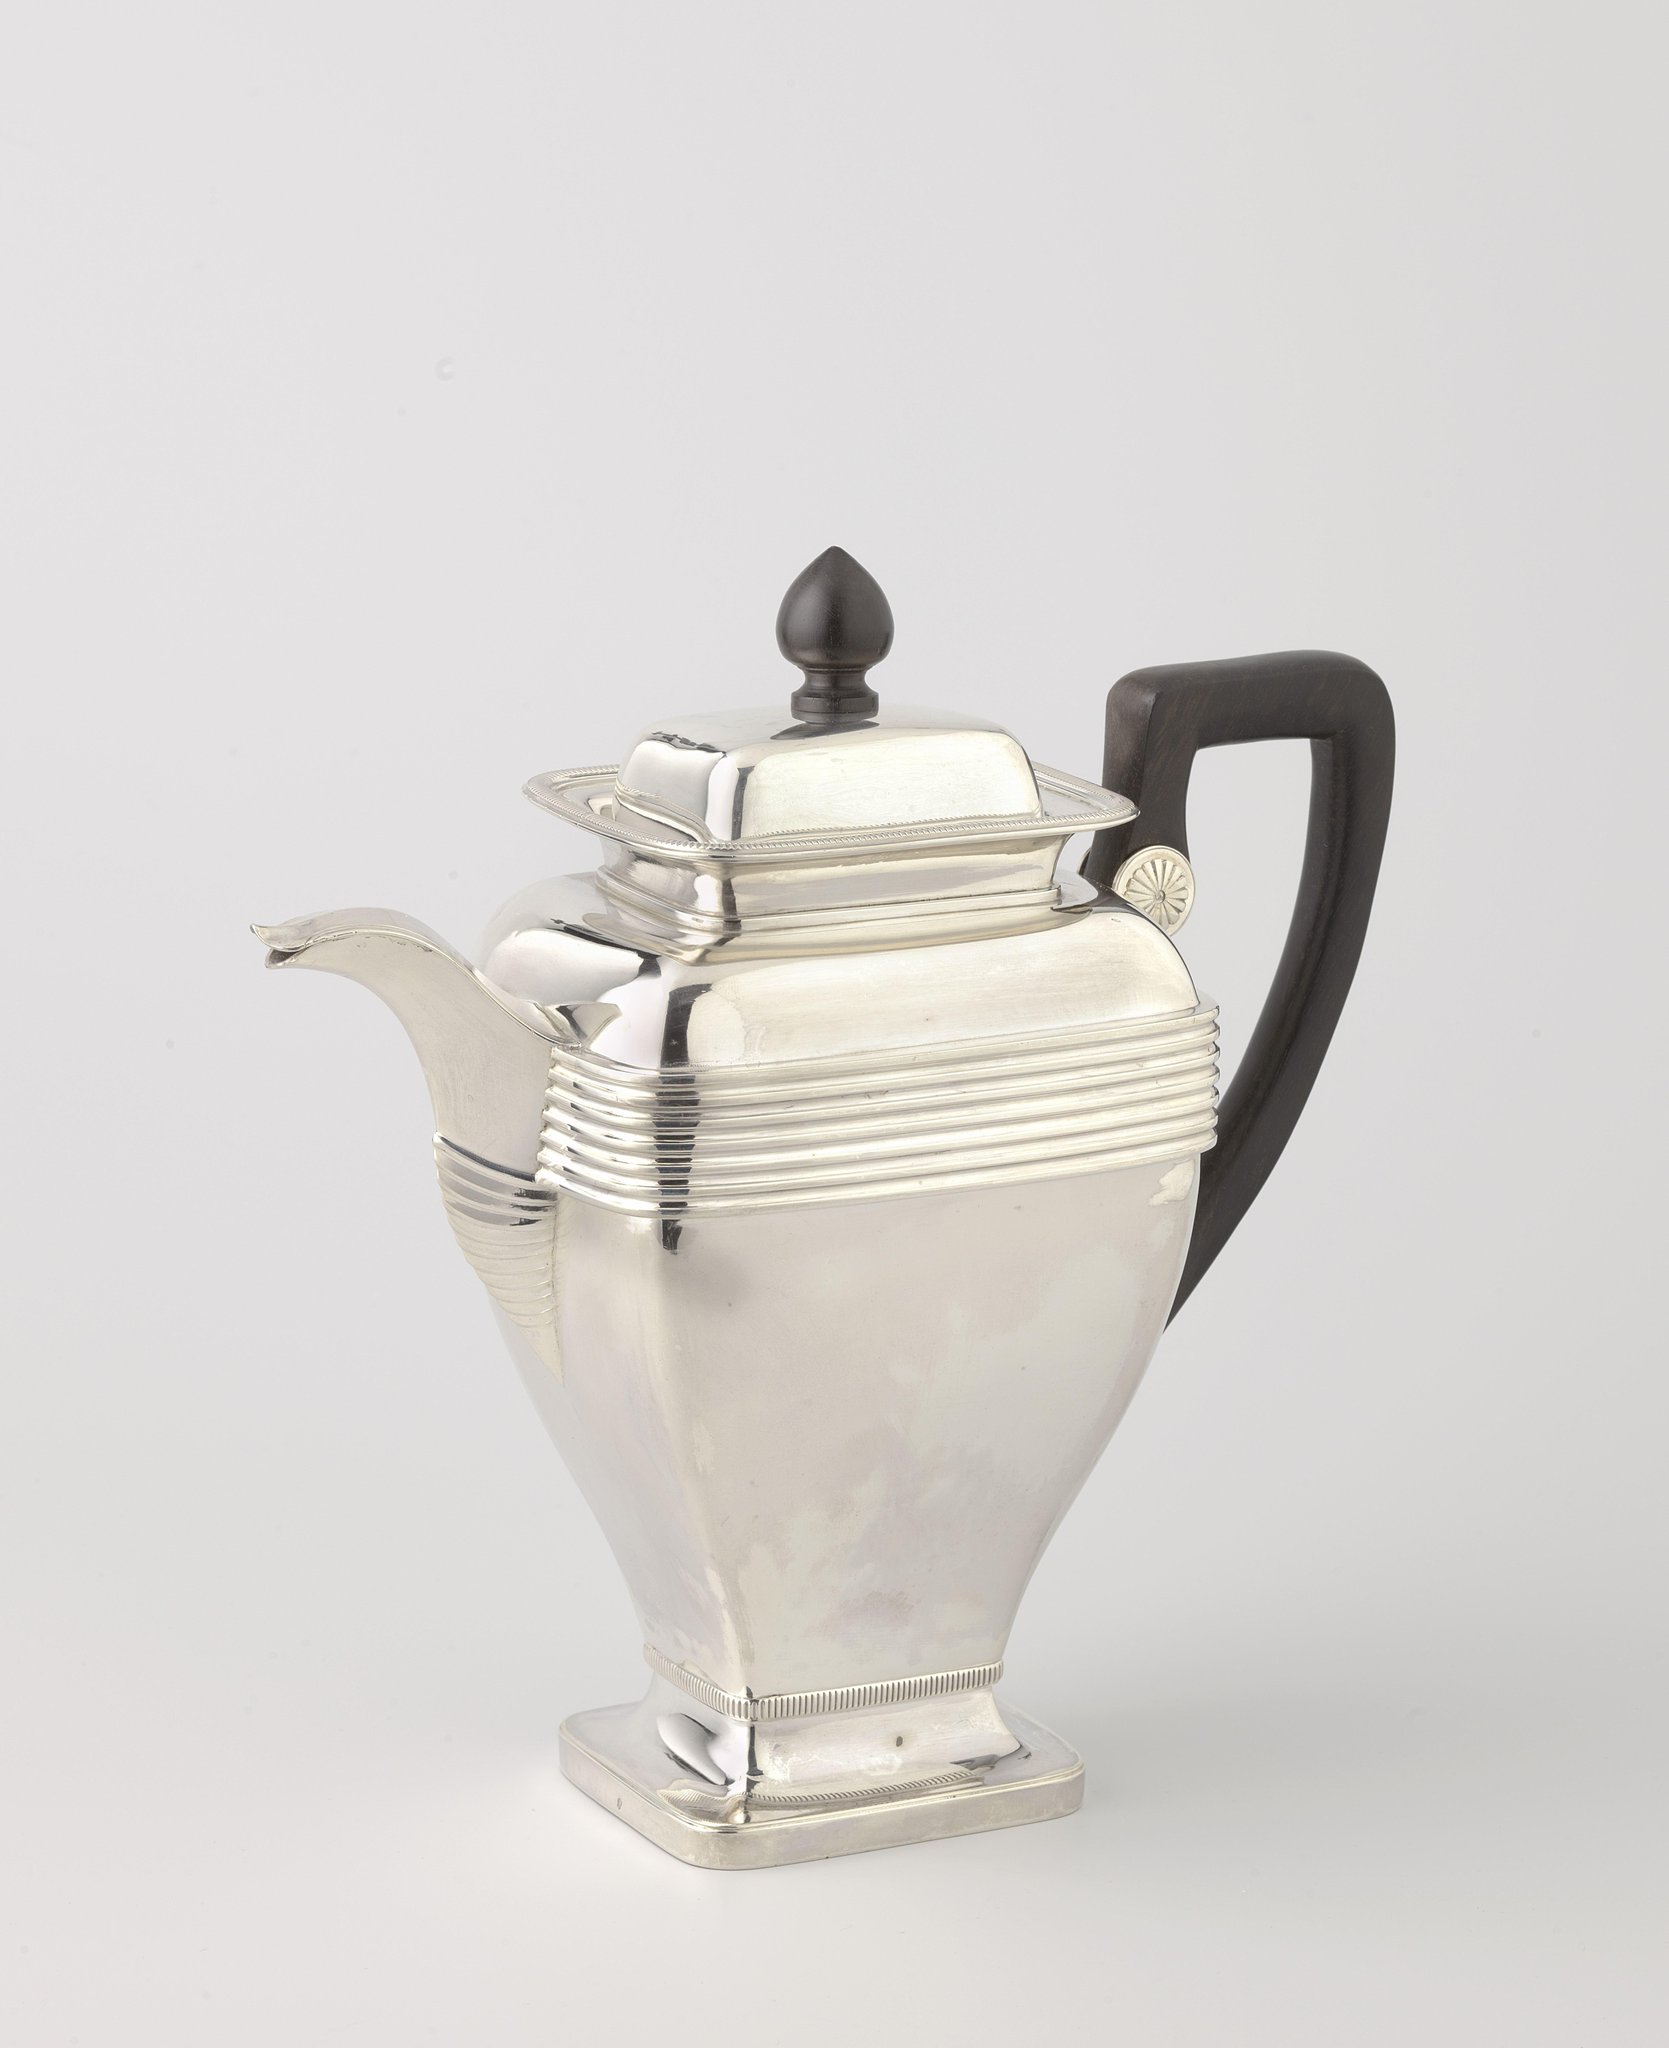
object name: coffee pot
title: Koffiekan, afgerond rechthoekig, met horizontaal geribde band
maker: diederik lodewijk bennewitz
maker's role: silversmith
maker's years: 1763-1826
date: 1824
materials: wood, silver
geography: amsterdam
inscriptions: maker's mark, : ‘ZI’, date letter: ‘P’, alloy mark, assayer's mark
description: Coffee pot. Silver, ebony handle and knob of lid. Amsterdam, 1824, by Diederik Lodewijk Bennewitz.